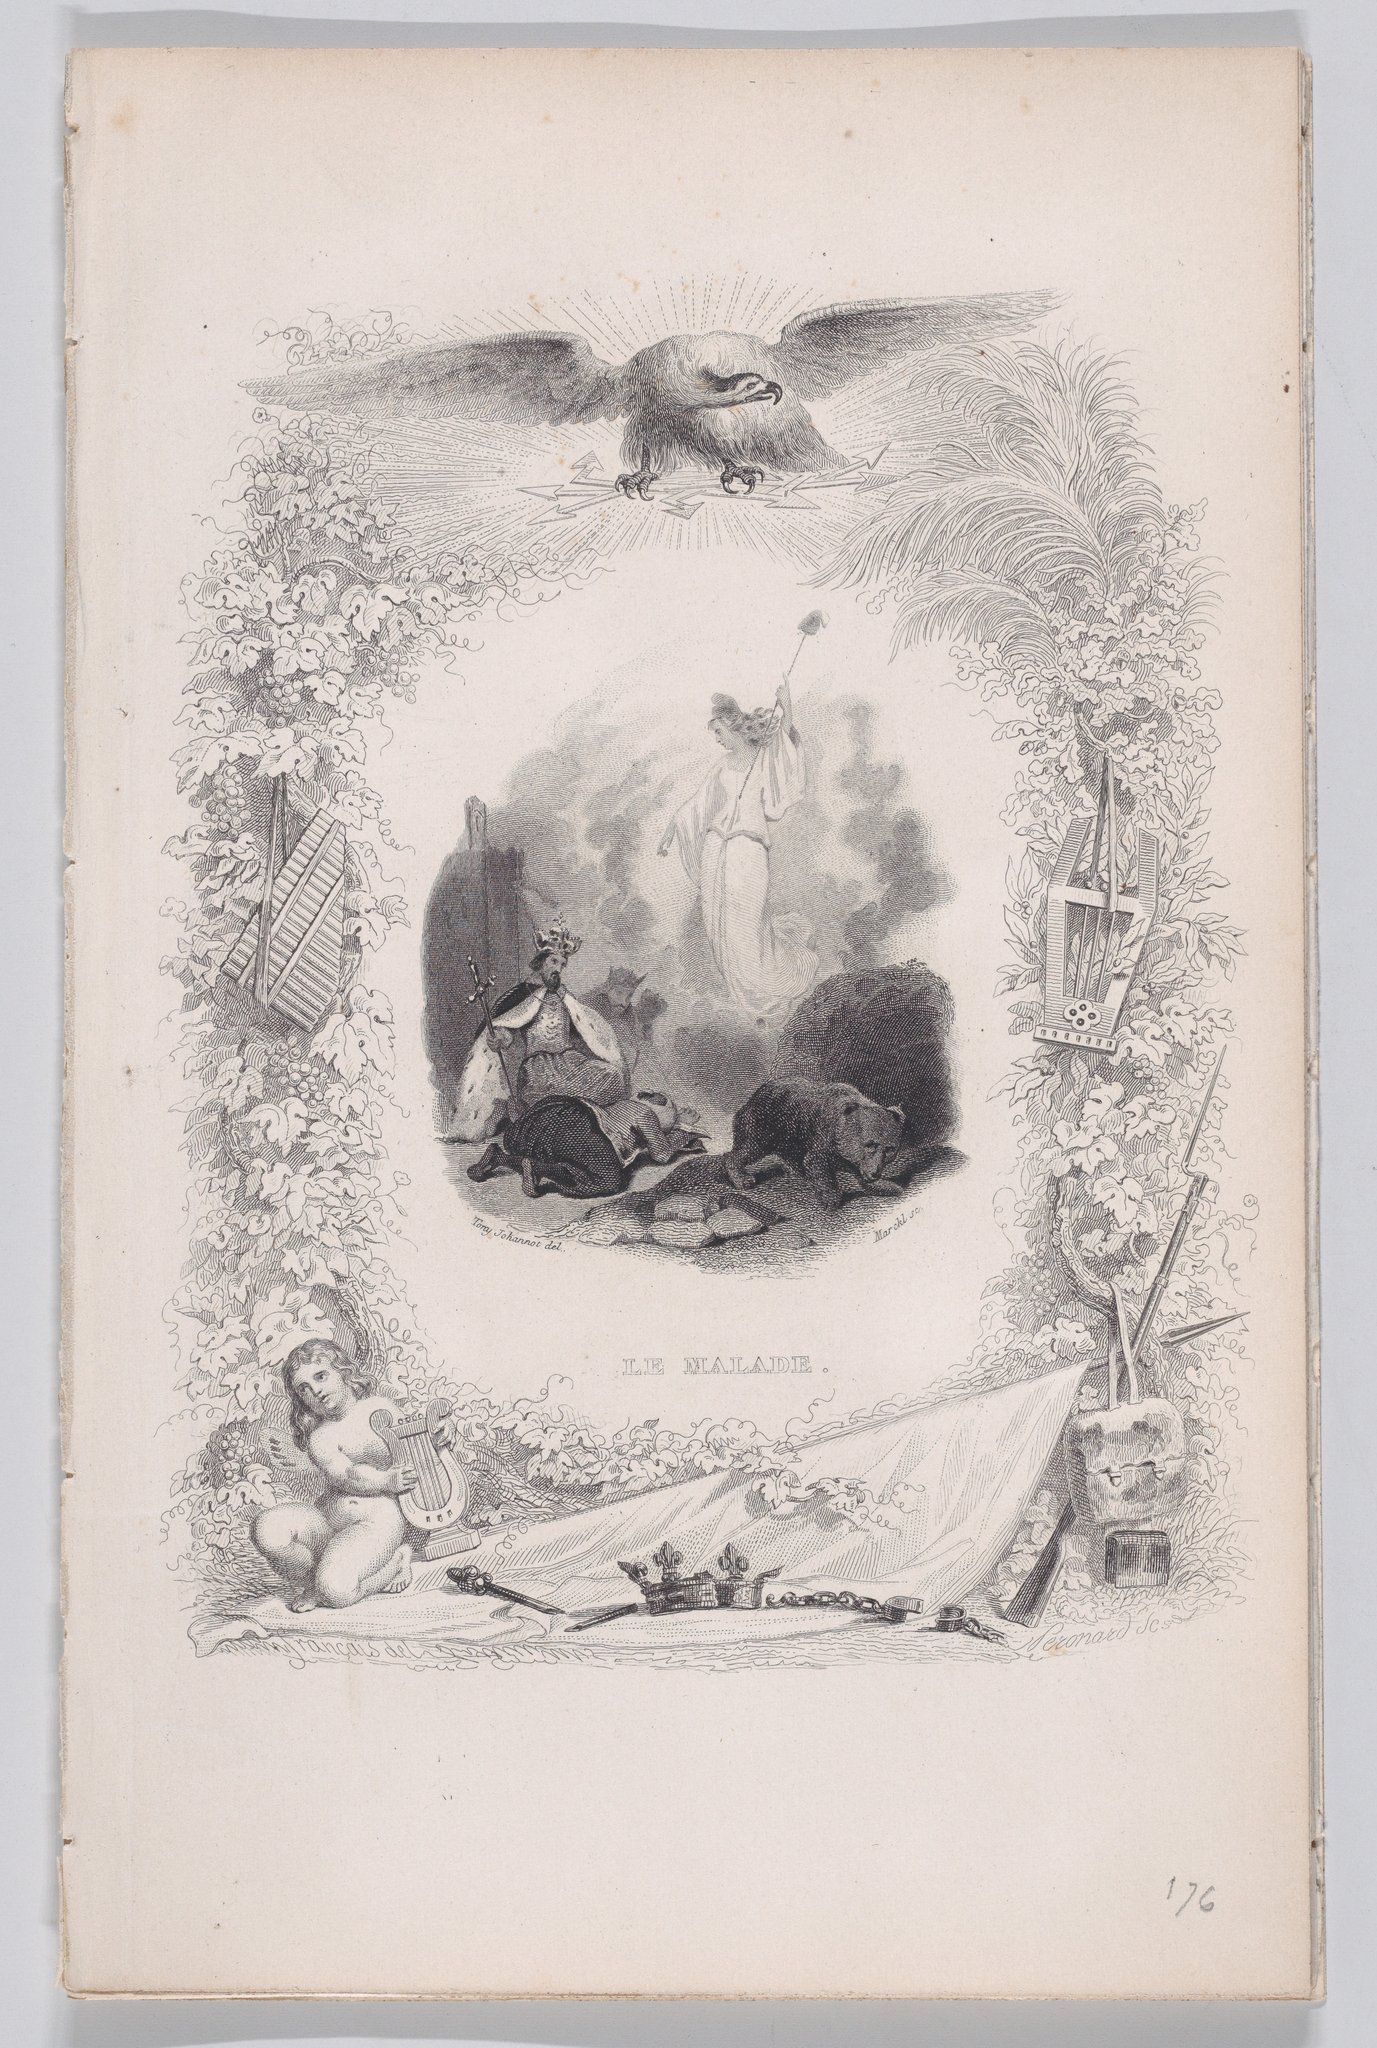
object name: print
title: The Diseased, from "The Complete Works of Béranger"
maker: tony johannot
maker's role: designer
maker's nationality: french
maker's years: 1803-1852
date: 1829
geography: paris